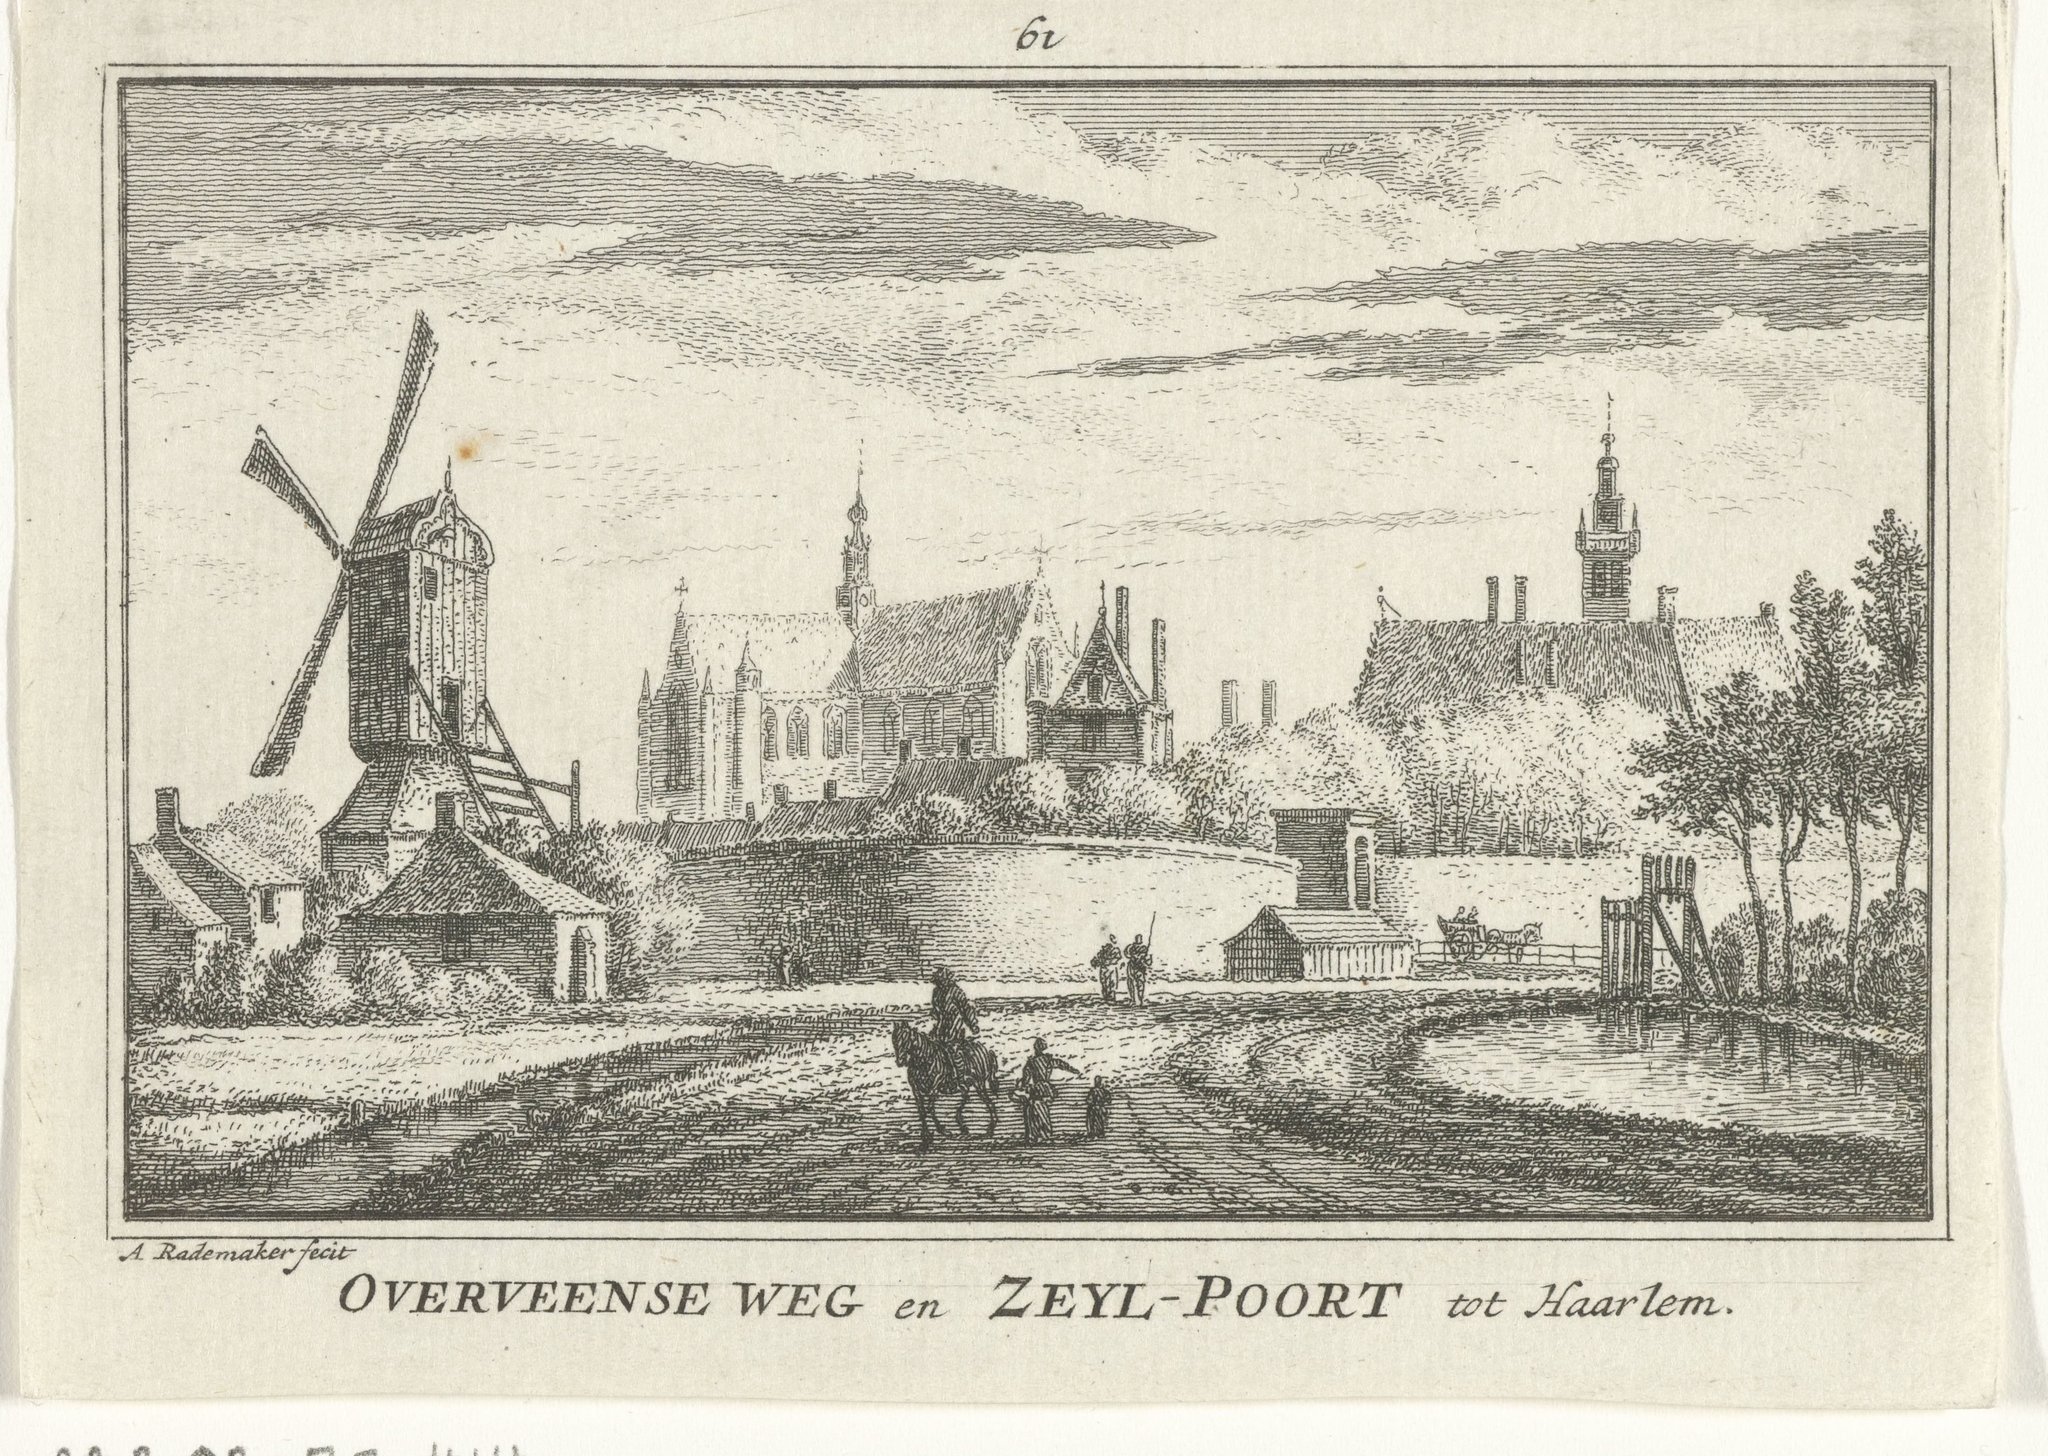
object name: book illustration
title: Overveense Weg en Zeyl-Poort tot Haarlem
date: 1727-1733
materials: paper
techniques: etching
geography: amsterdam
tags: windmill, city-gate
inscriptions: collector's mark: Lugt 2228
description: Illustratie uit: Abraham Rademaker, Matthaeus Brouërius van Niedek, Isaac Le Long, Kabinet van Nederlandsche en Kleefsche outheden en (...) voorname stads- en landgebouwen, Willem Barents en Antoni Schoonenburg: Amsterdam, 1727-1733, ill. nr. 61.